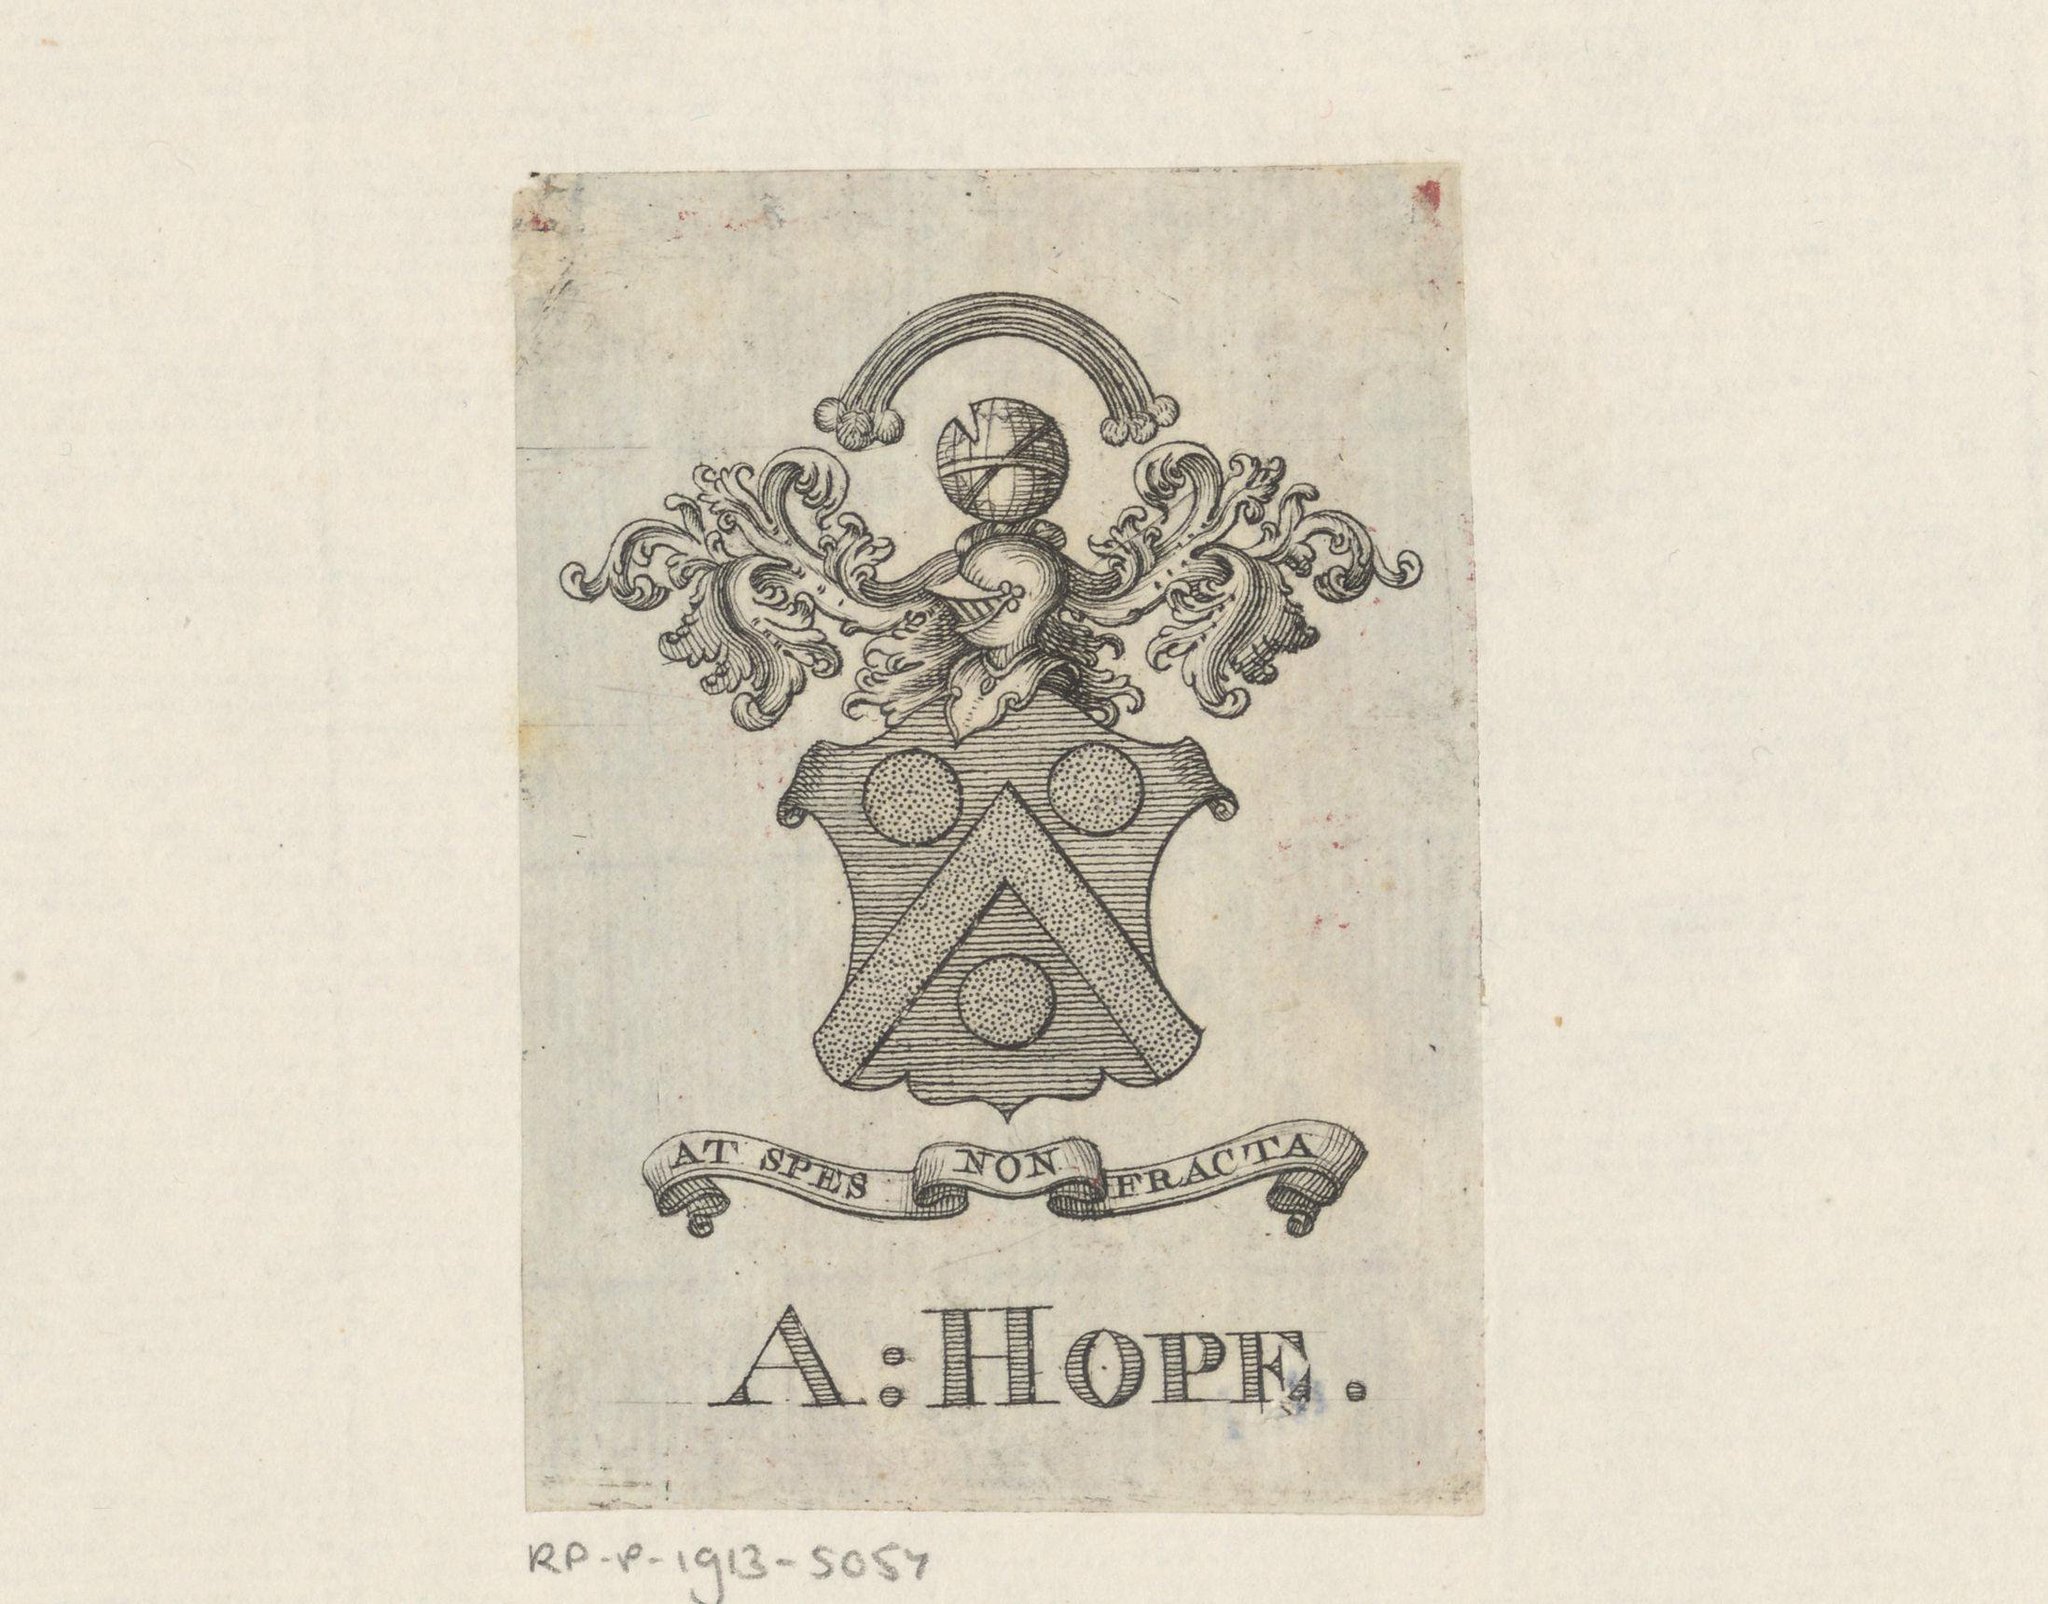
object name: bookplate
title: A: Hope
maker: Anonymous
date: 1757-1821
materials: paper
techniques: etching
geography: netherlands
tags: rotterdam, the hague, archibald hope, globe, armorial bearing, heraldry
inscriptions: collector's mark: Lugt 2233, collector's mark: Lugt 2760